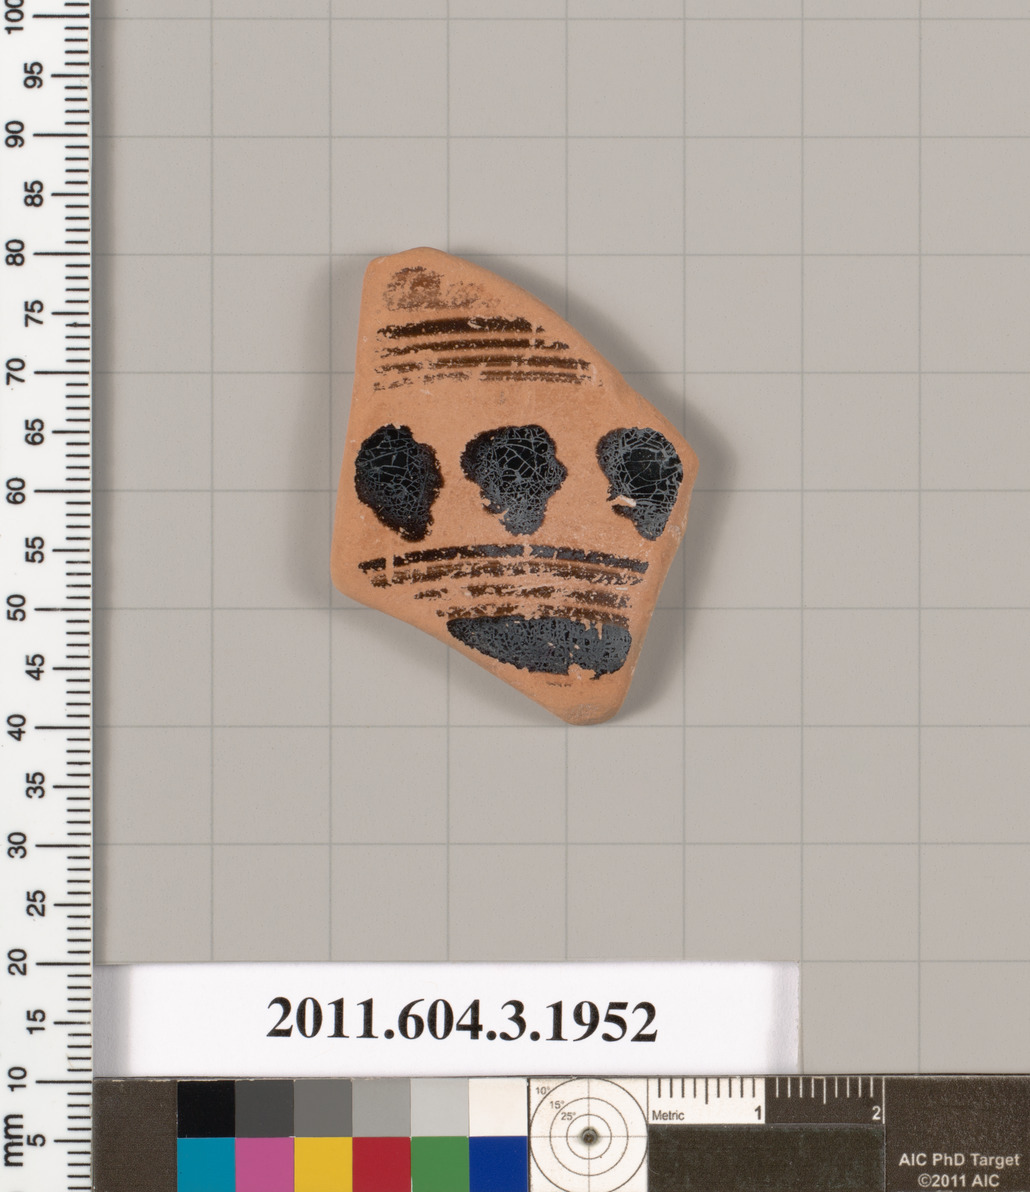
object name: kylix fragment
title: Terracotta fragment of a kylix: Droop cup (drinking cup)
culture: greek, attic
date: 567-535 BCE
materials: terracotta